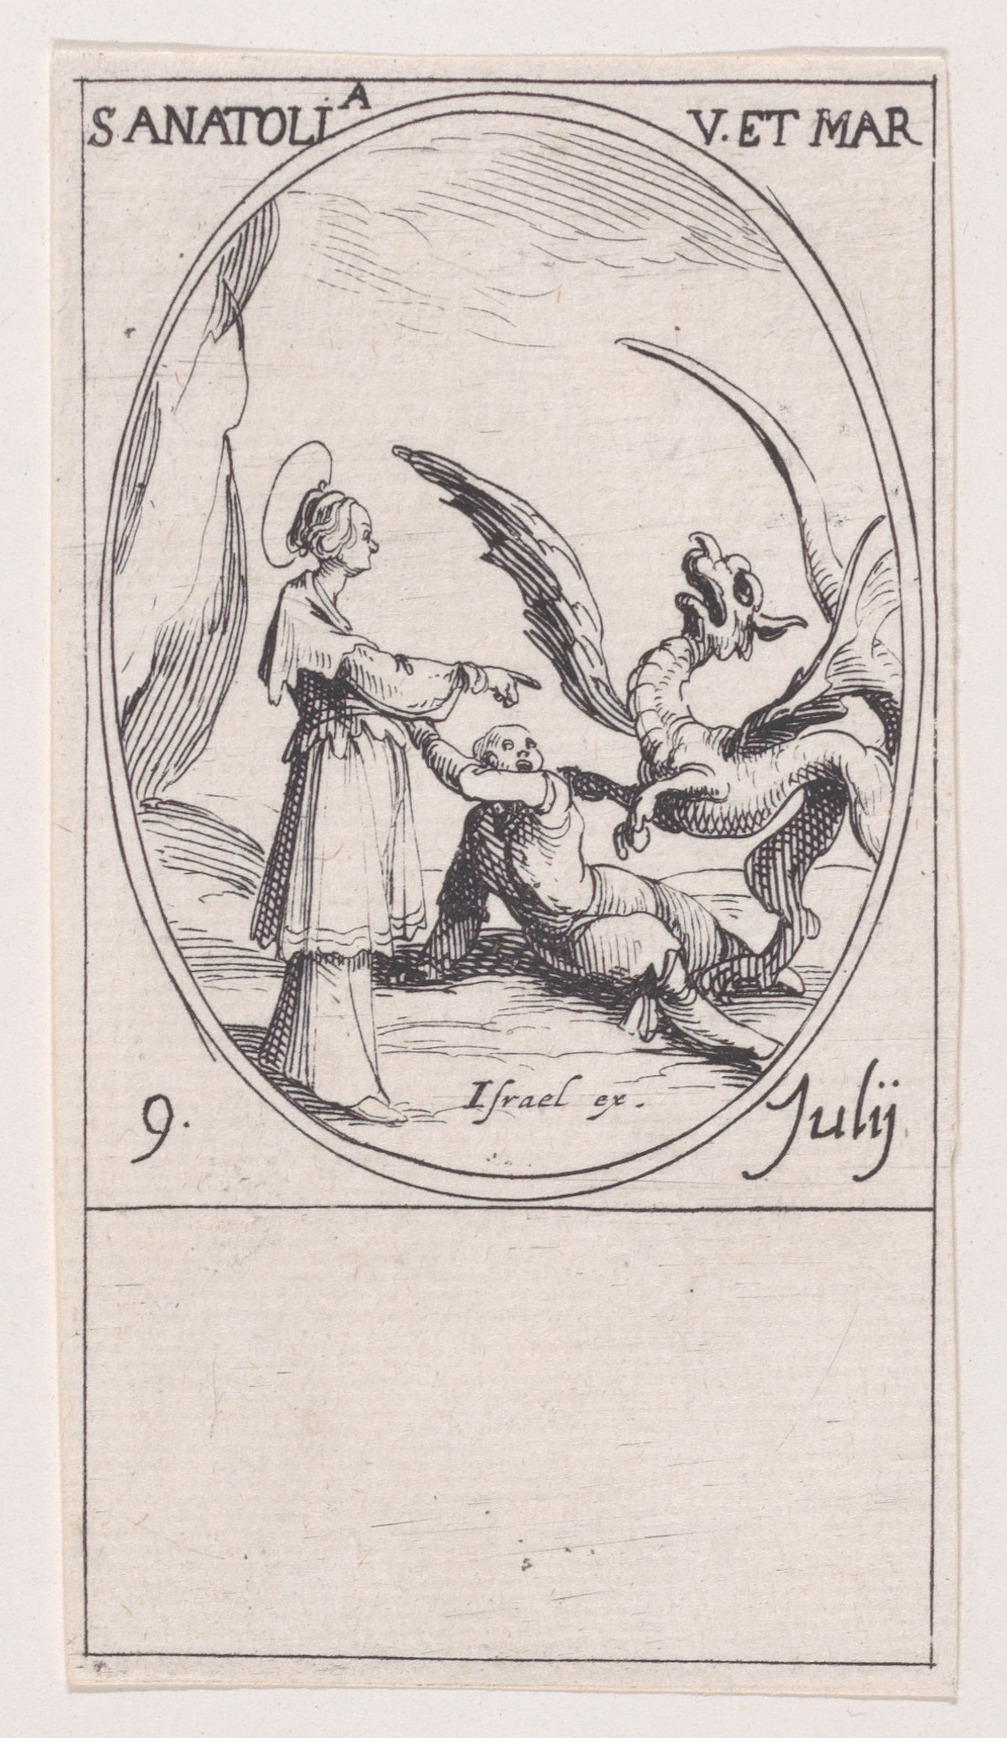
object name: print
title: Ste. Anatolie, vierge et martyre (St. Anatolia, Virgin and Martyr), July 9th, from "Les Images De Tous Les Saincts et Saintes de L'Année" (Images of All of the Saints and Religious Events of the Year)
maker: jacques callot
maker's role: artist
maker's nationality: french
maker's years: 1592-1635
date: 1632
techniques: etching